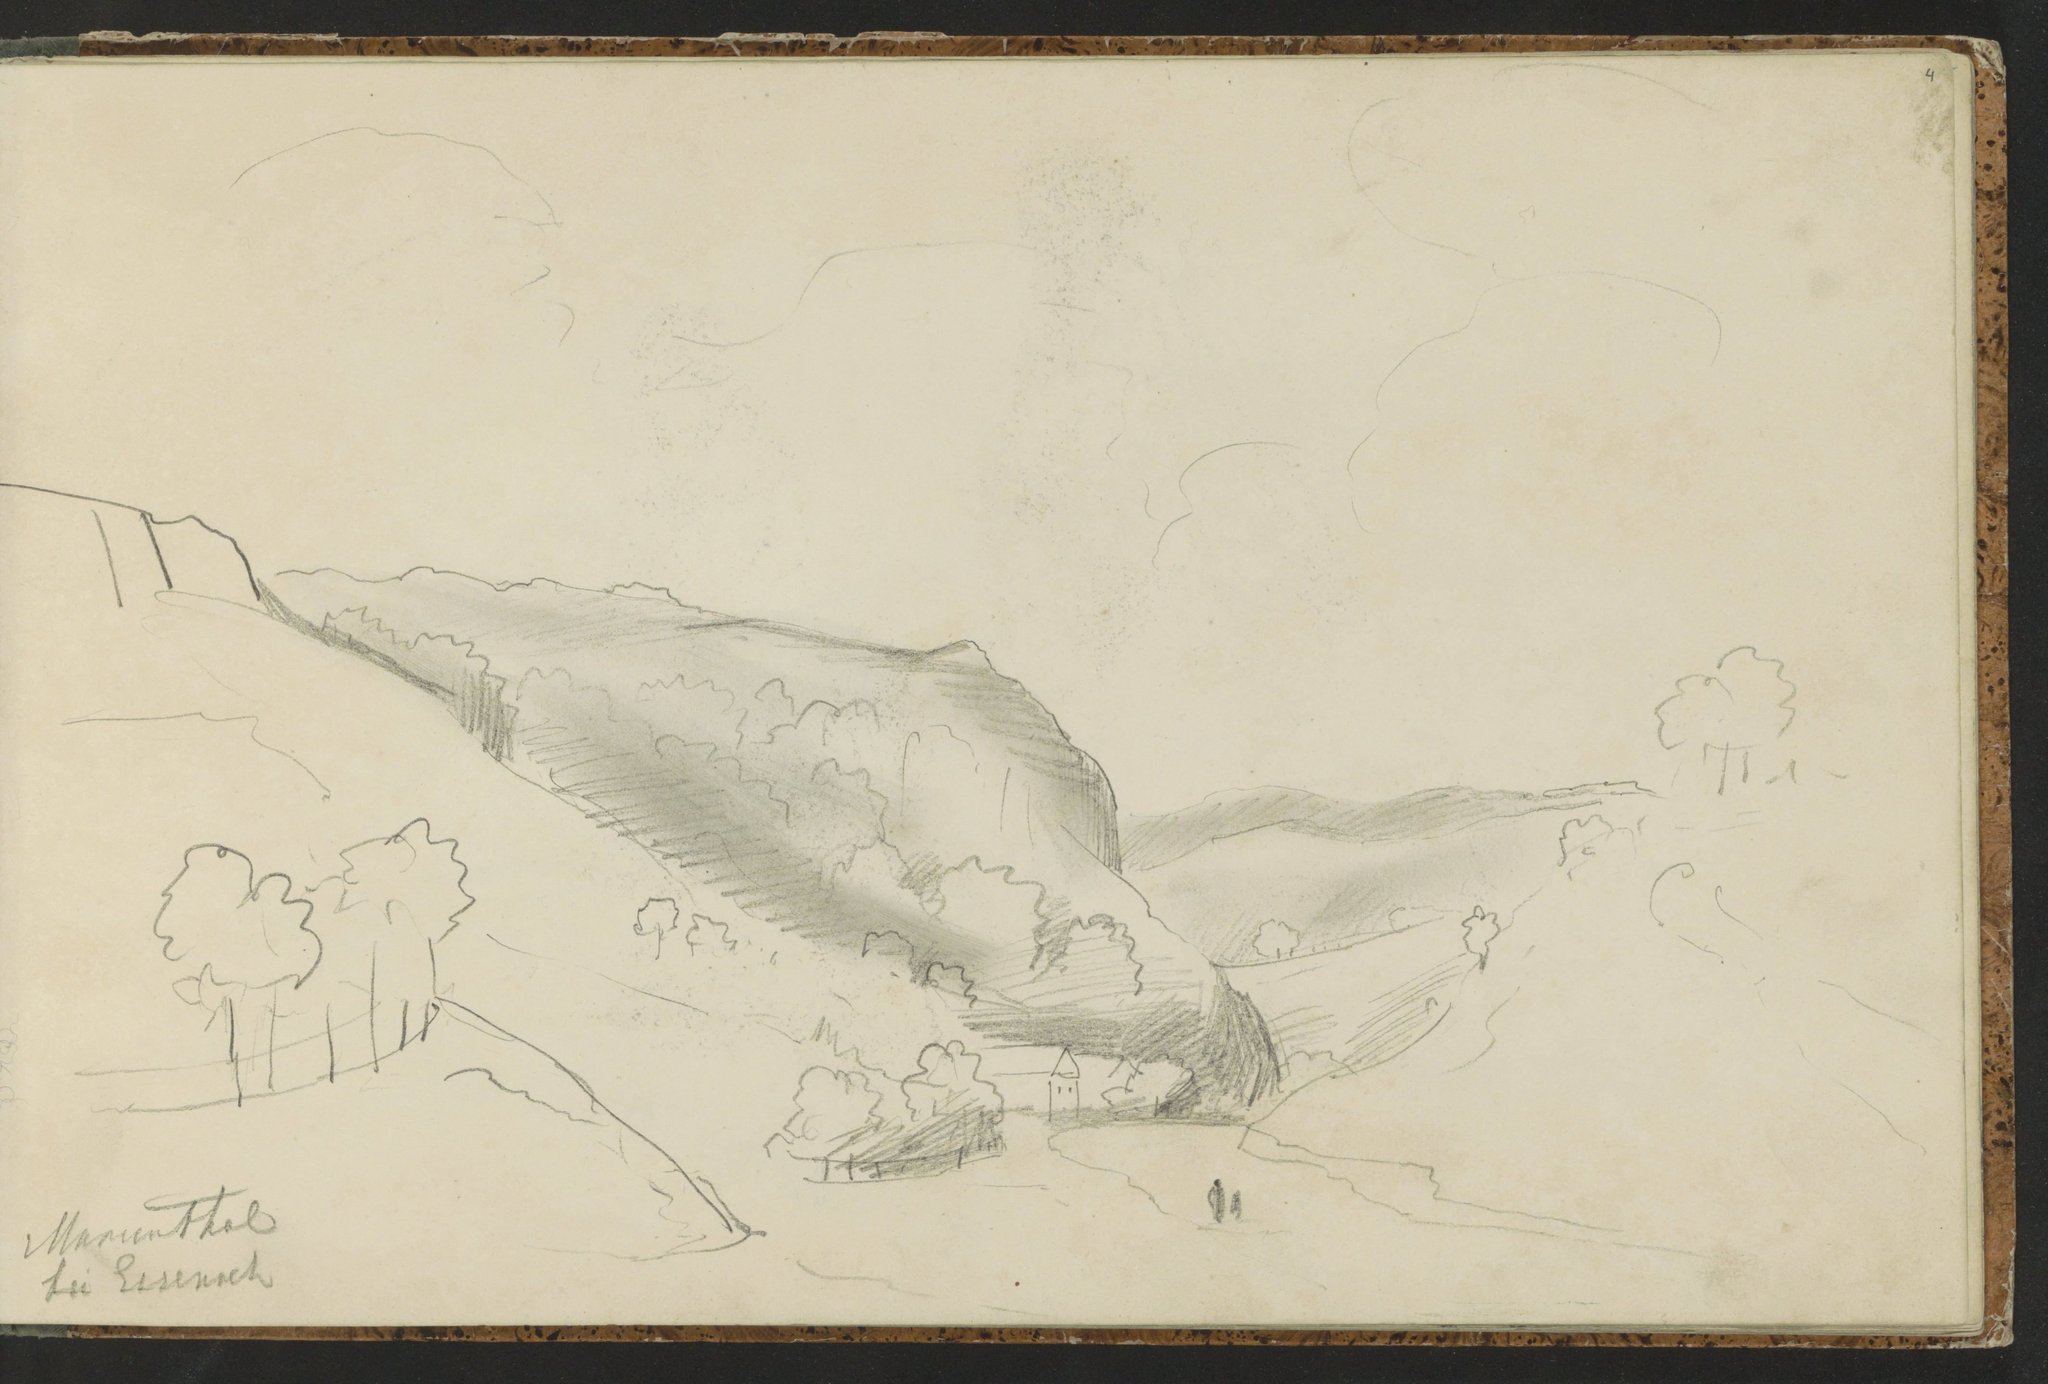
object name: sketchbook leaf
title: Marienthal bij Eisenach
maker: johannes tavenraat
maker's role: draughtsman, painter, print maker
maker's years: 1809-1881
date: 1840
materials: paper, pencil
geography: eisenach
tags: dale, valley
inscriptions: annotation: ‘Marienthal/ bei Eisenach’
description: Blad 4 recto uit een schetsboek met 33 bladen.